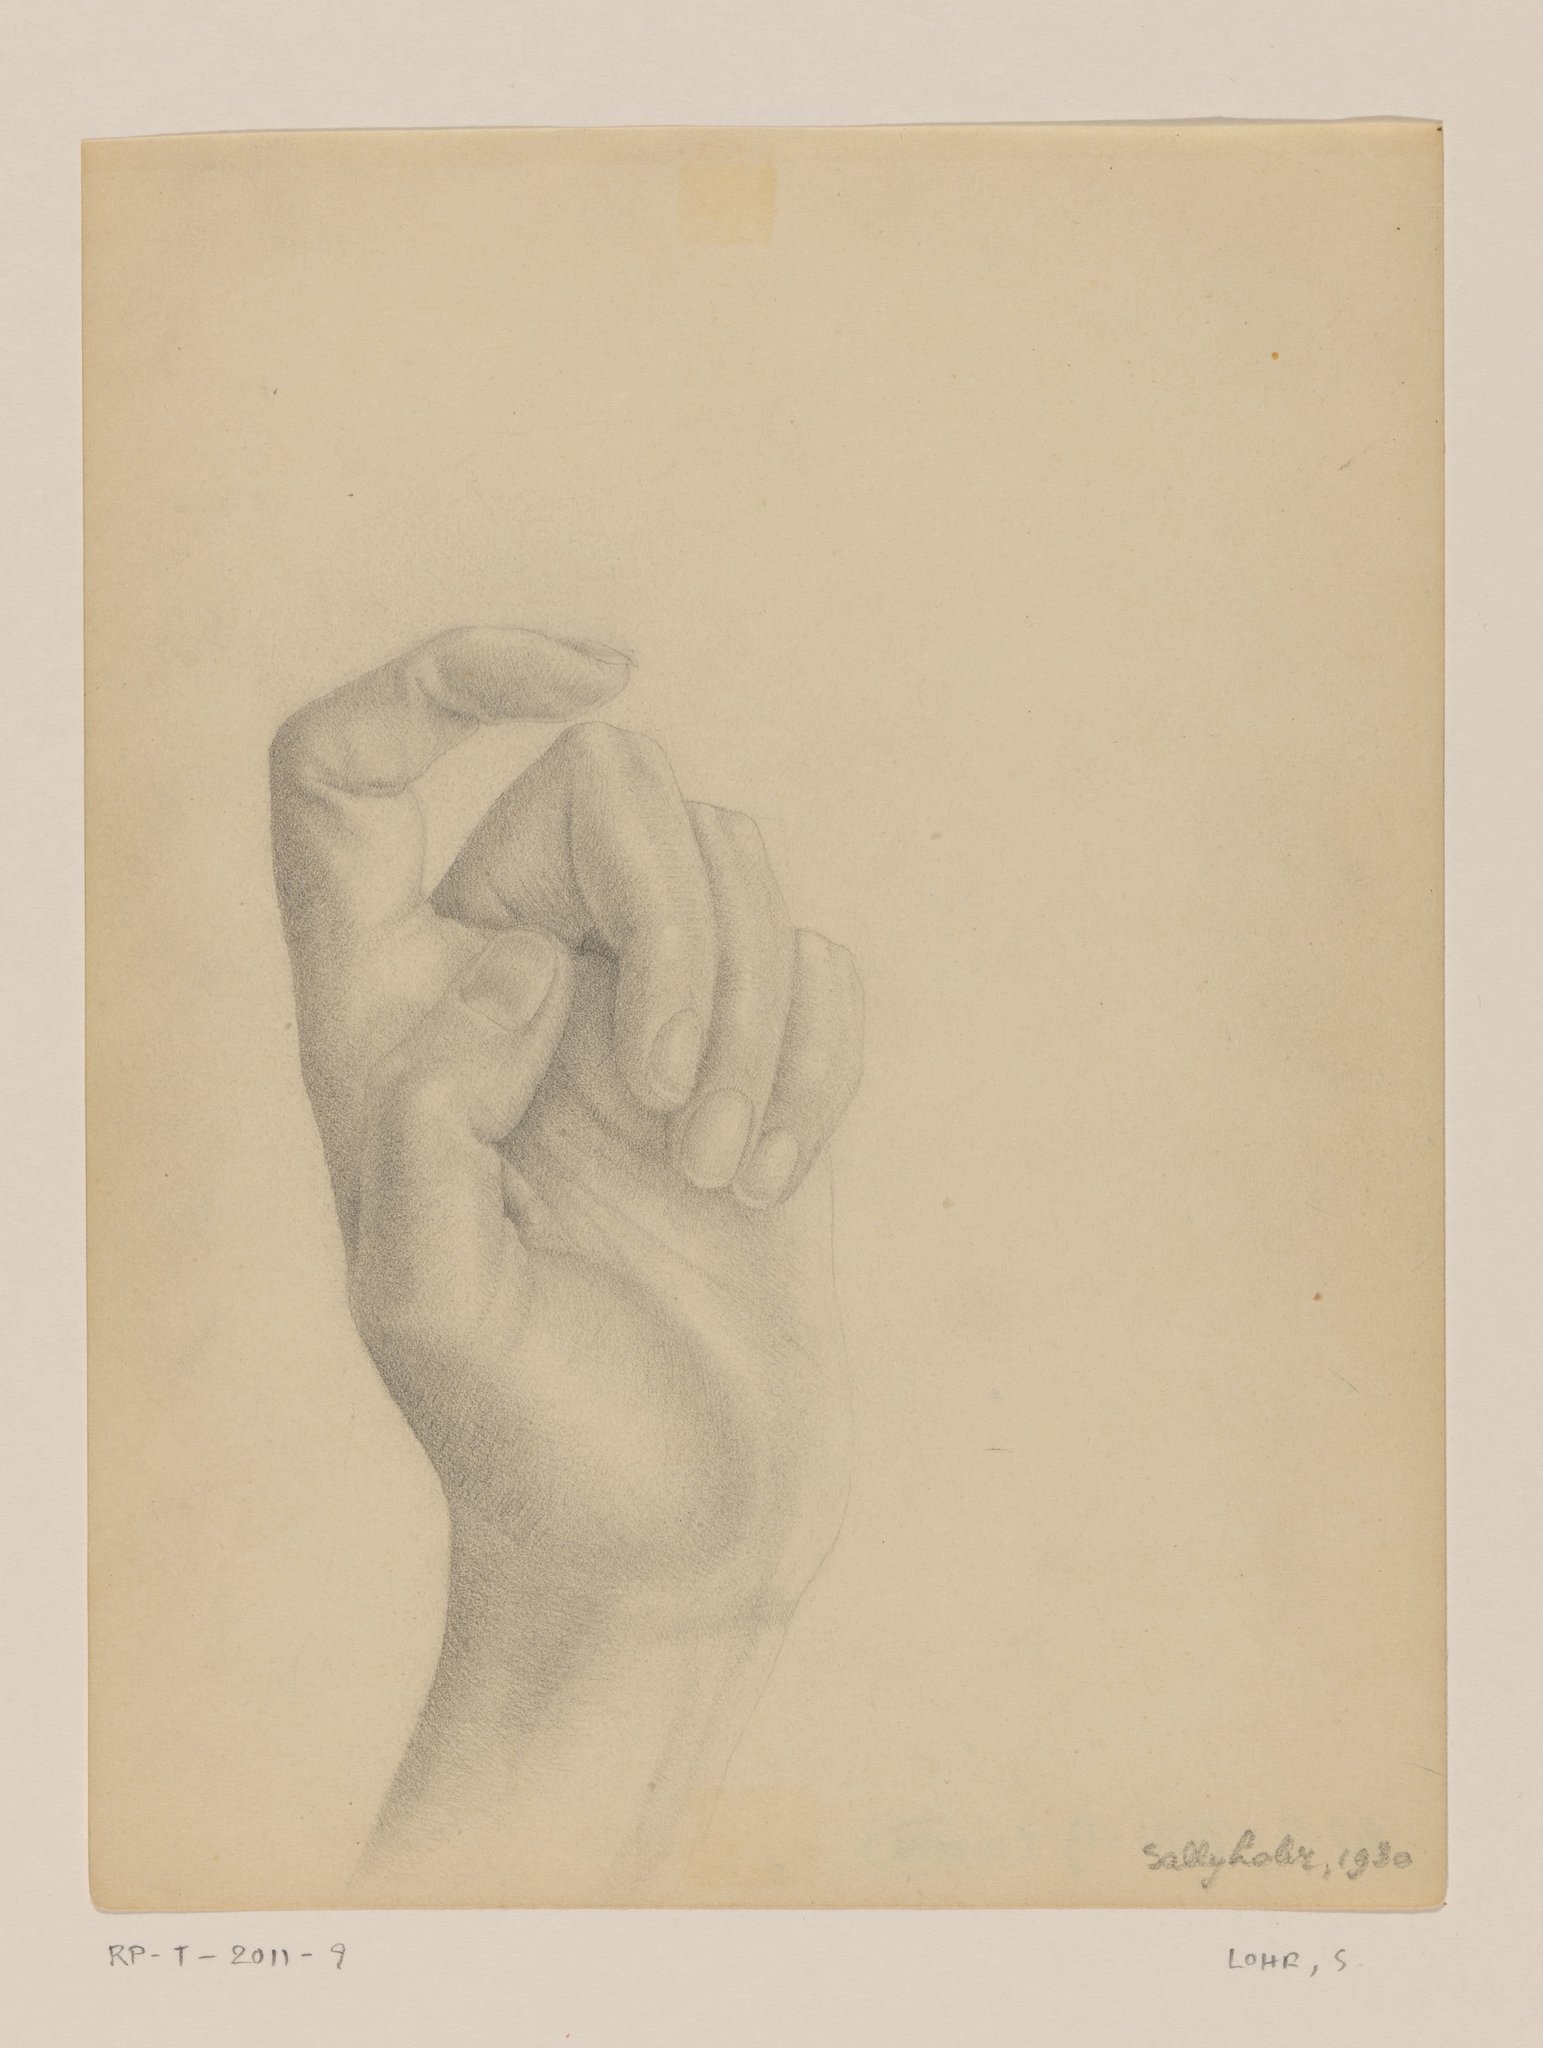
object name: drawing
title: Studie hand met gebogen vingers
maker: sally lohr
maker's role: draughtsman, painter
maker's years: 1905-1950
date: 1930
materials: paper, pencil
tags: hand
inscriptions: collector's mark: Lugt 2228